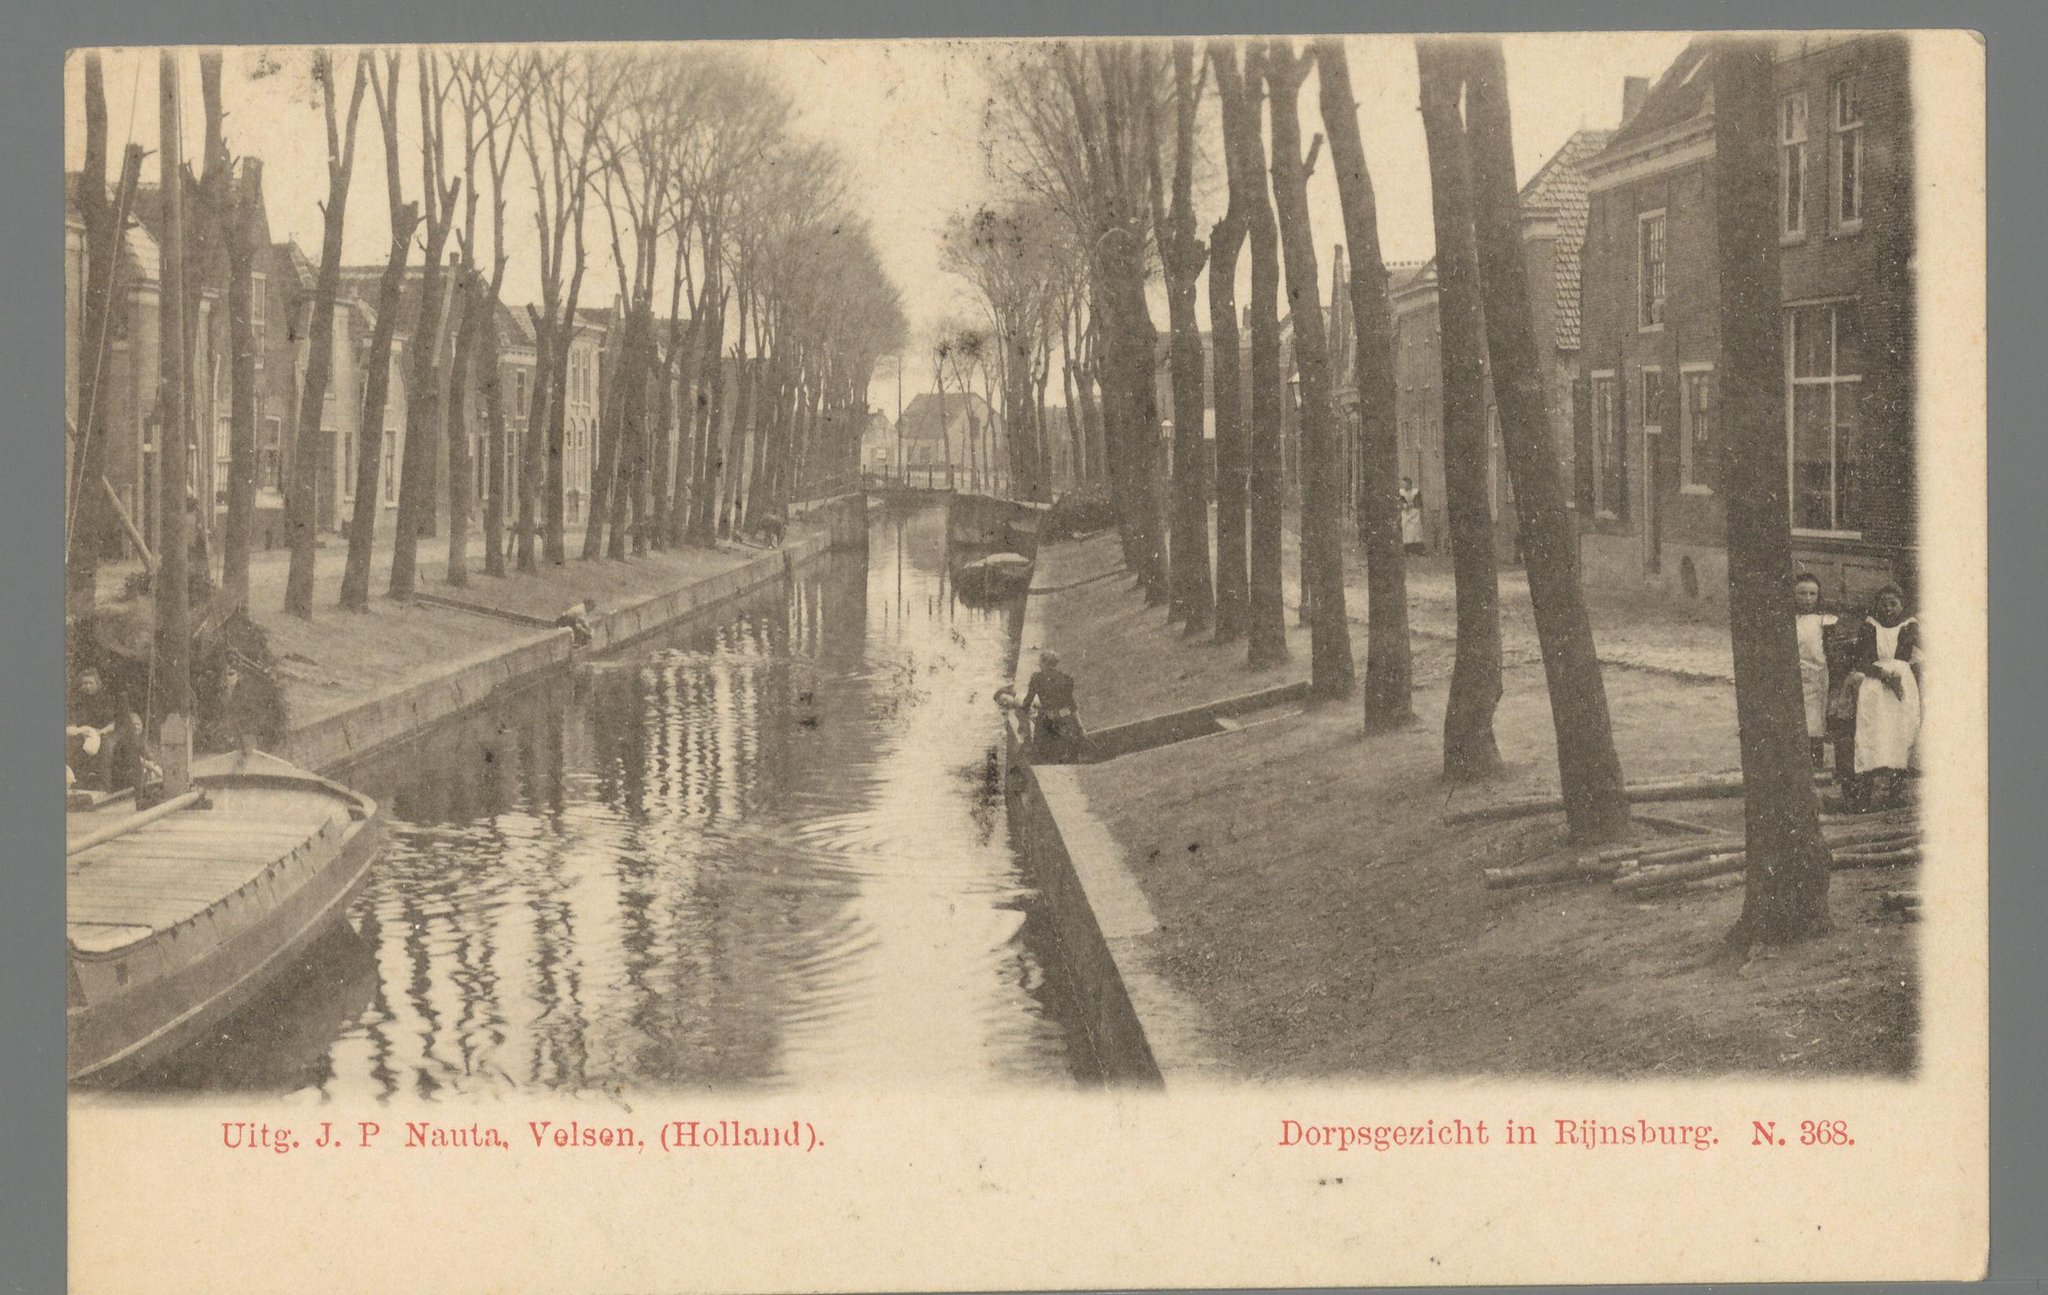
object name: photomechanical print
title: Dorpsgezicht in Rijnsburg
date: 1897-1905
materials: cardboard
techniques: photograph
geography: velsen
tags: canals, waters (in village), street